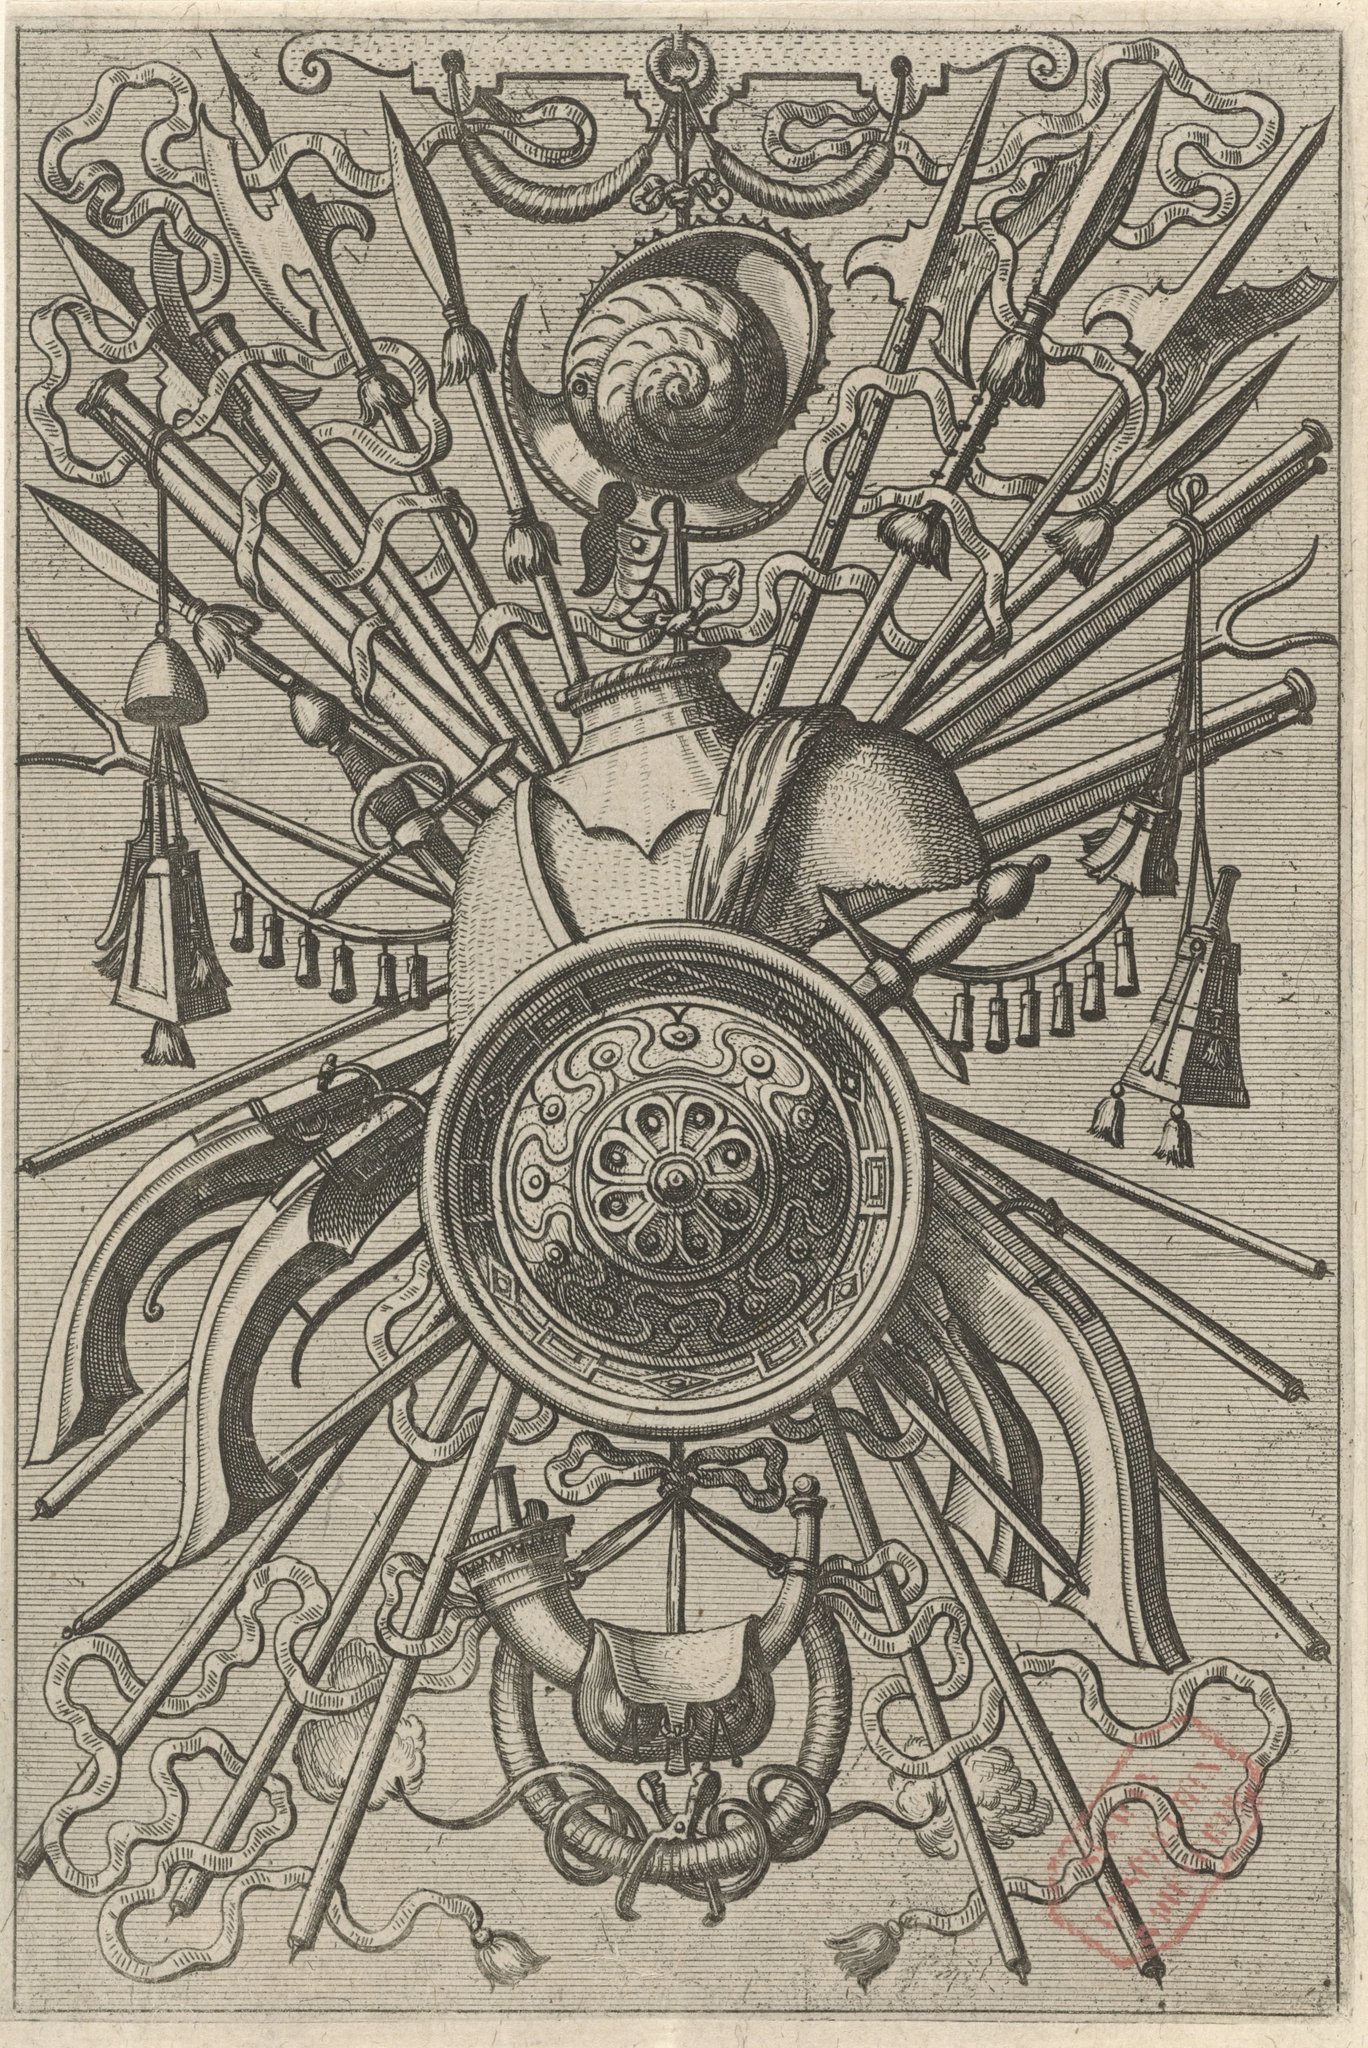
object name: ornament print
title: Panoplia sev armamentarium…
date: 1572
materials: paper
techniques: etching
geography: netherlands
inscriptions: collector's mark: Lugt 2275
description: Een helm, een harnas, karabijnen en diverse steekwapens. Uit serie, bestaande uit een titelblad en 16 bladen.